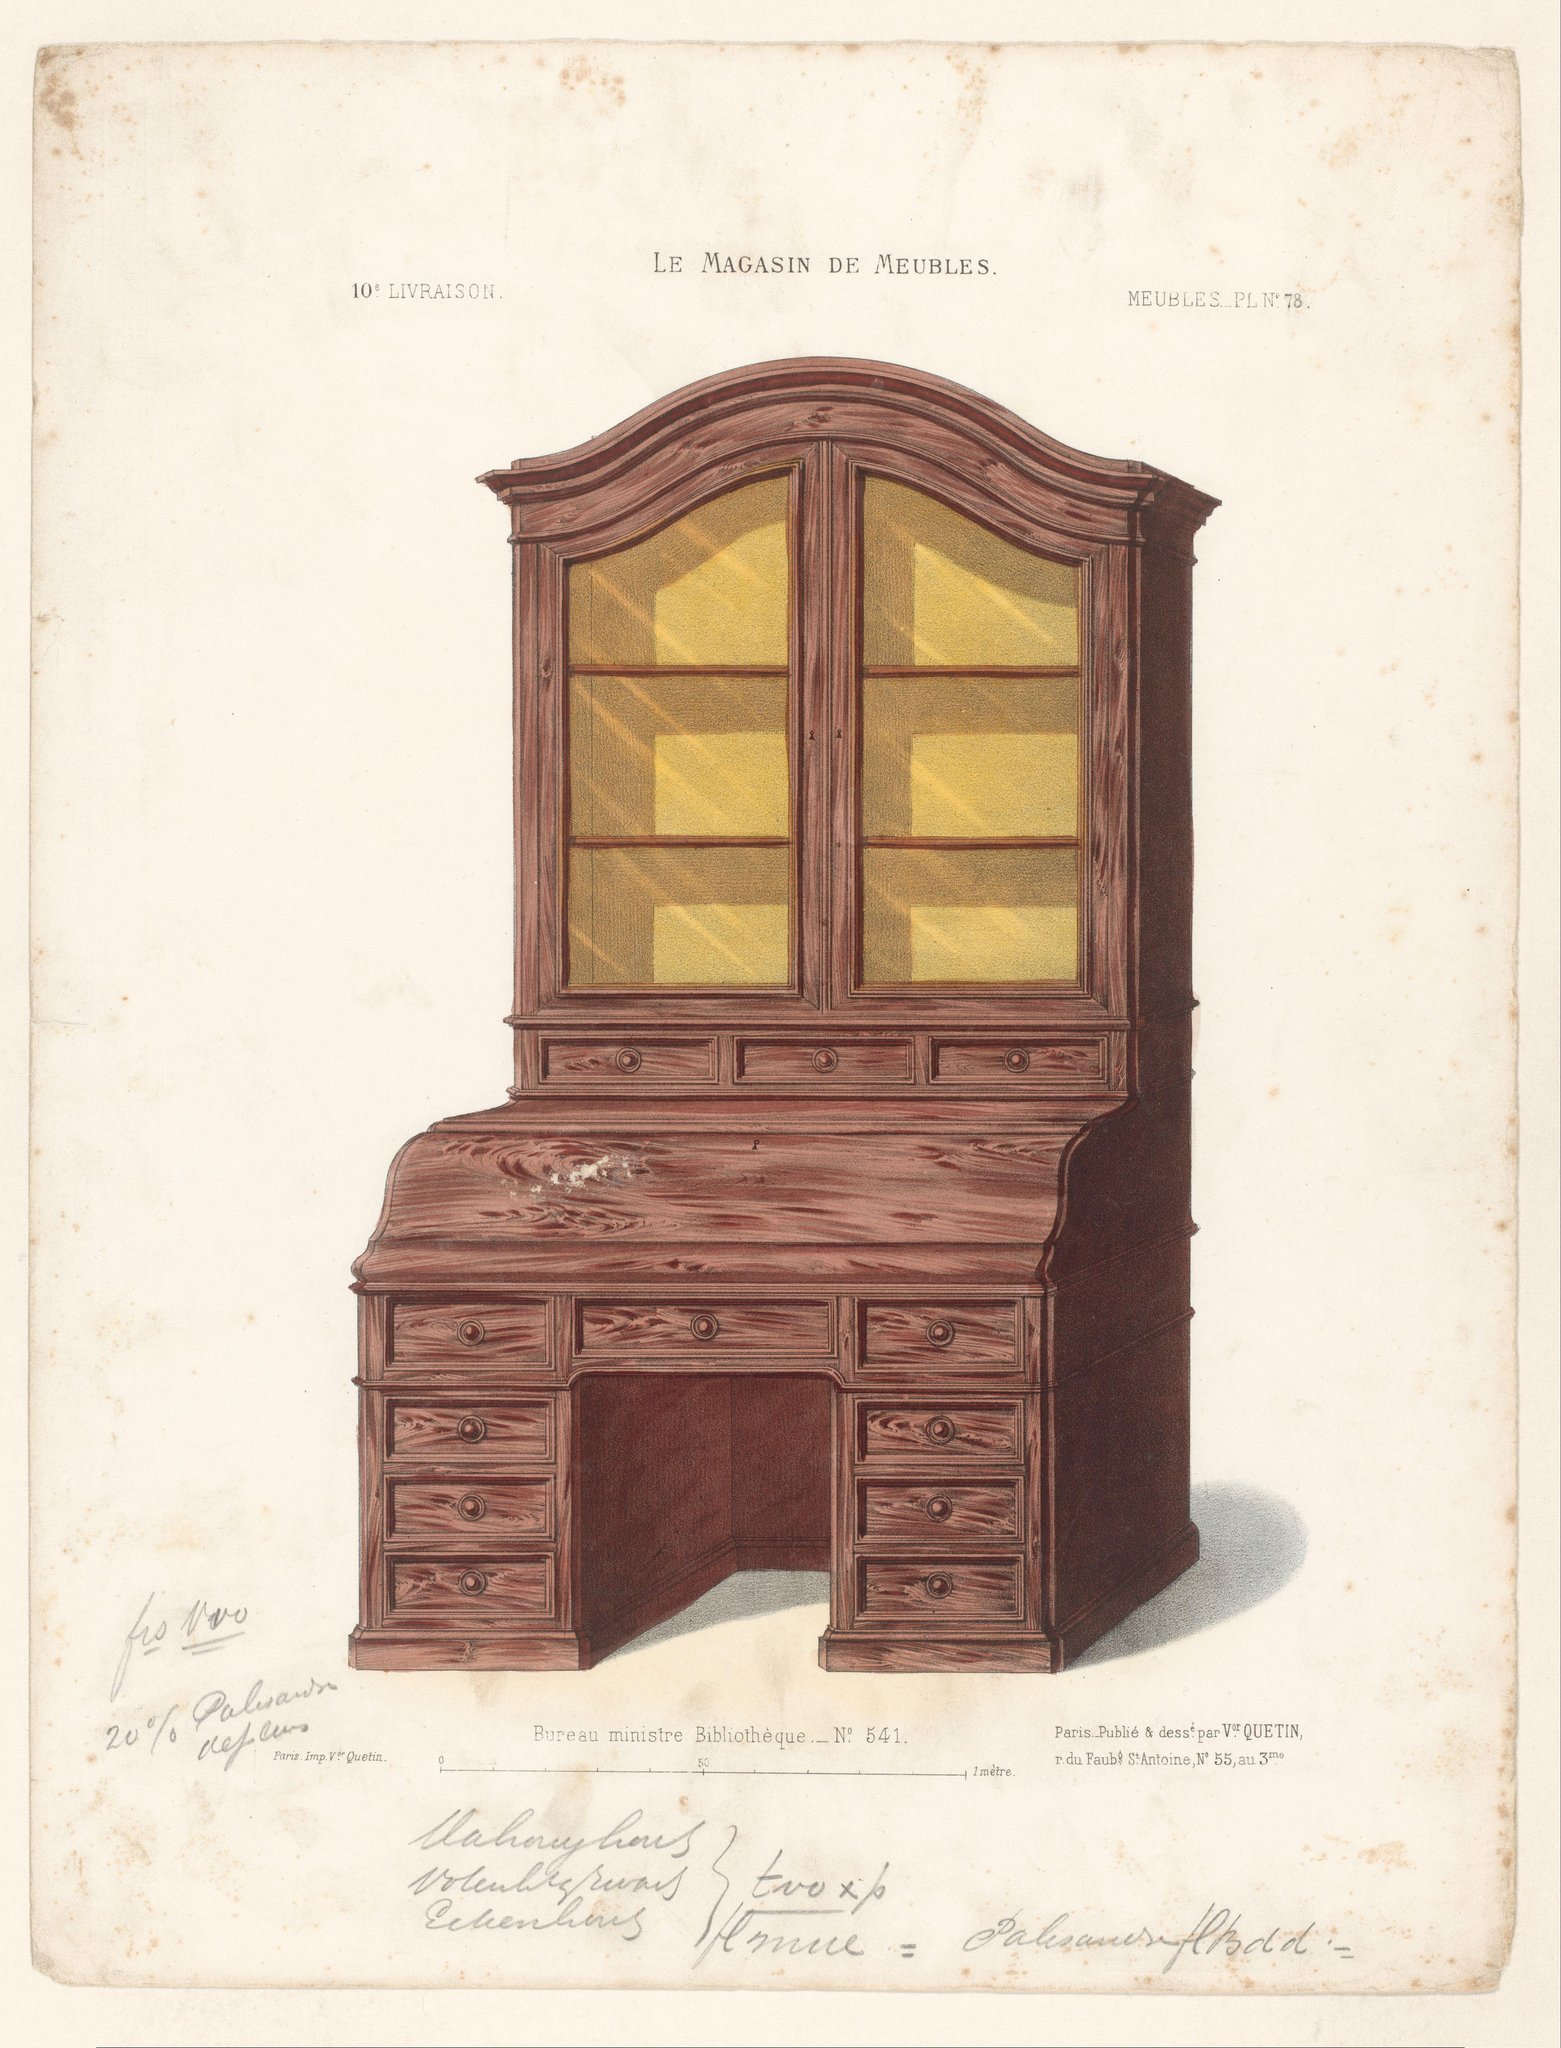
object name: print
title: Le Magasin de Meubles / Meubles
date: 1832-1877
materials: paper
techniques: hand coloring, lithograph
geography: paris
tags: writing-table, writing-desk, furniture for storage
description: Een bureau met boekenkast. Prent uit 10e Livraison.